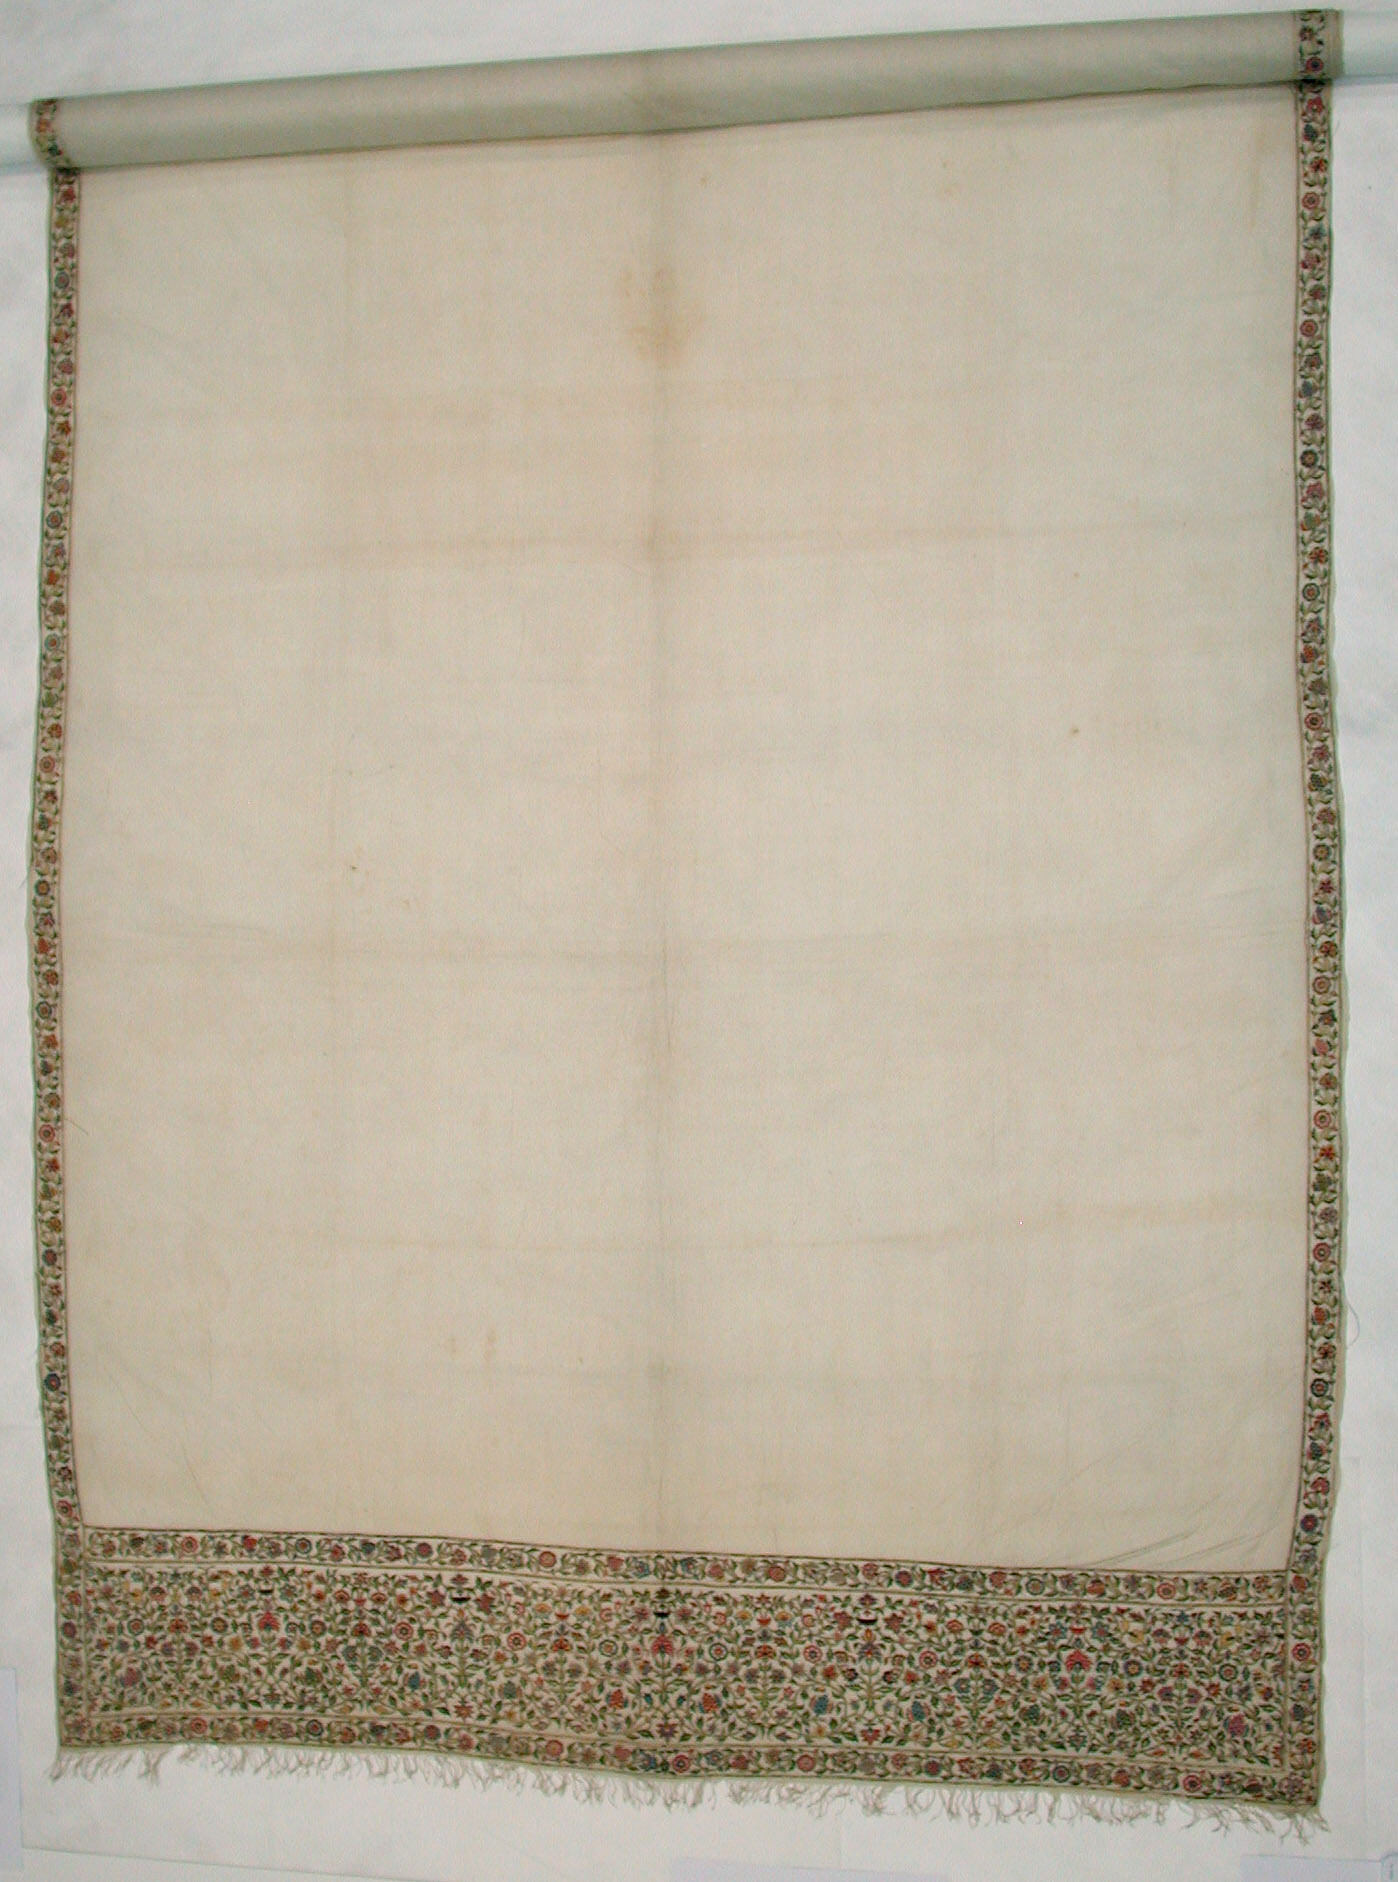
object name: scarf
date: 1701-1800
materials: cotton, metal thread, silk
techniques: embroidery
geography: india